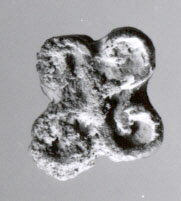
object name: stamp seal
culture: bactria-margiana archaeological complex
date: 2333-1668 BCE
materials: copper alloy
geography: bactria-margiana